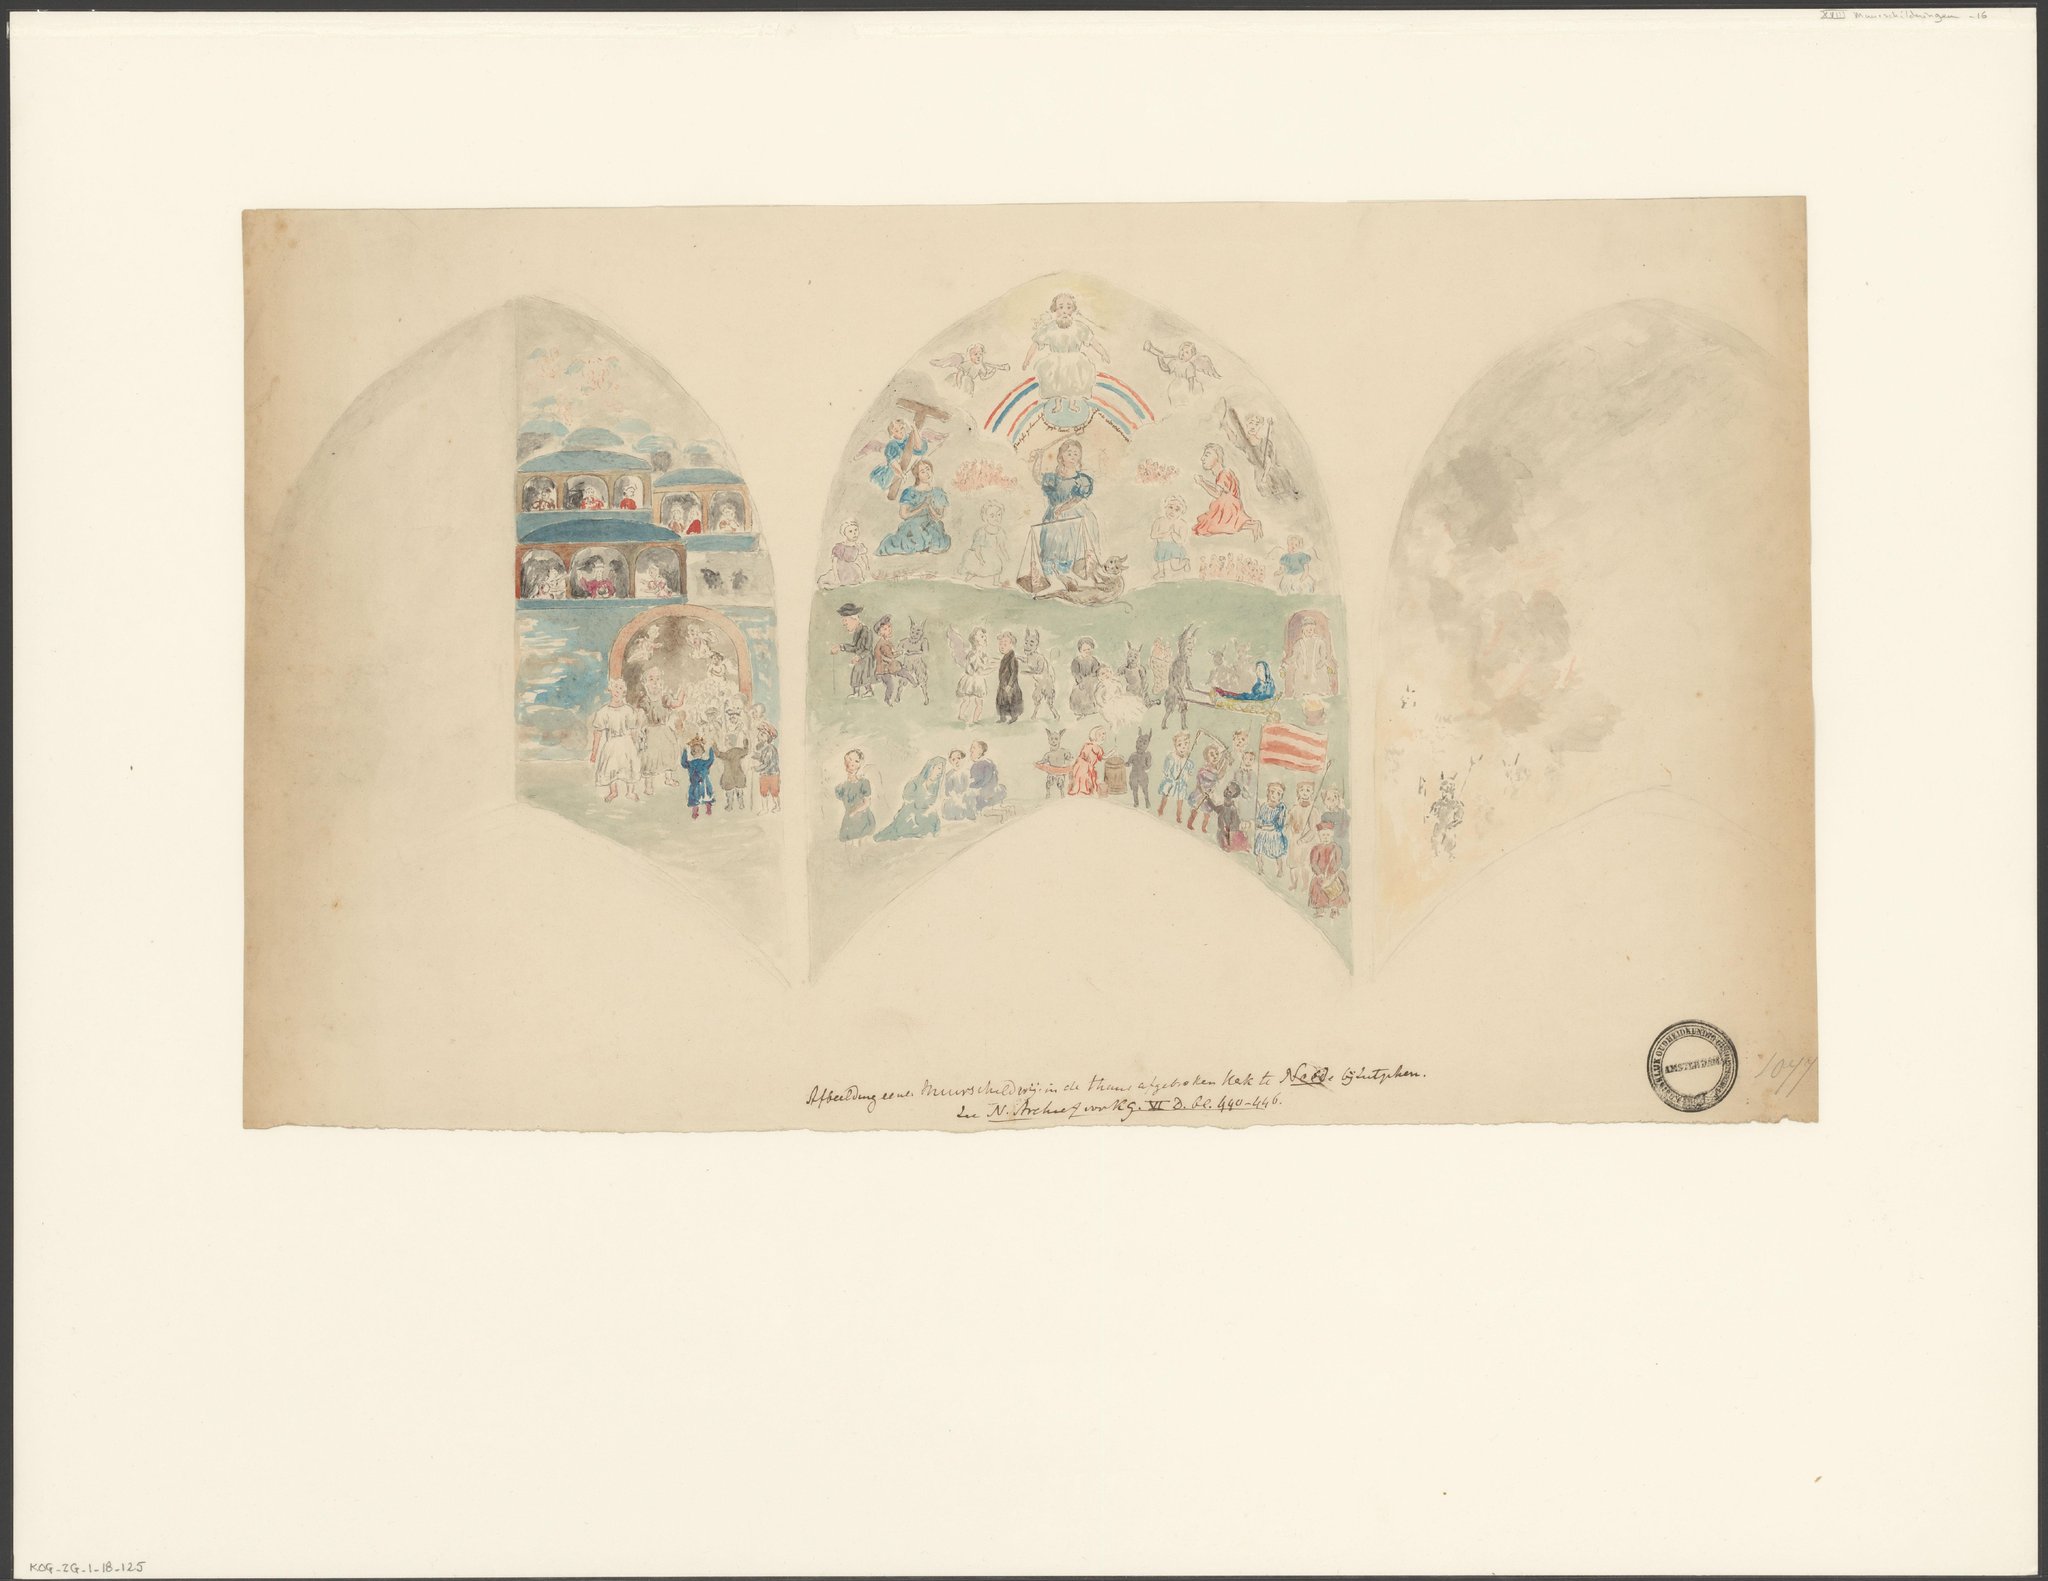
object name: drawing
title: Muurschildering met het Laatste Oordeel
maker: Anonymous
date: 1846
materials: paper, pencil, watercolor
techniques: brush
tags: last judgement, painting (including book-illumination, miniature-painting)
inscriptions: stamp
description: Muurschildering met het Laatste Oordeel, uit de in 1846 afgebroken St. Ceciliakerk te Neede. Onderwerpsrubrieken binnen de Atlas Zeden en Gewoonten: Schoone kunsten, Muur- en gewelfschilderingen.